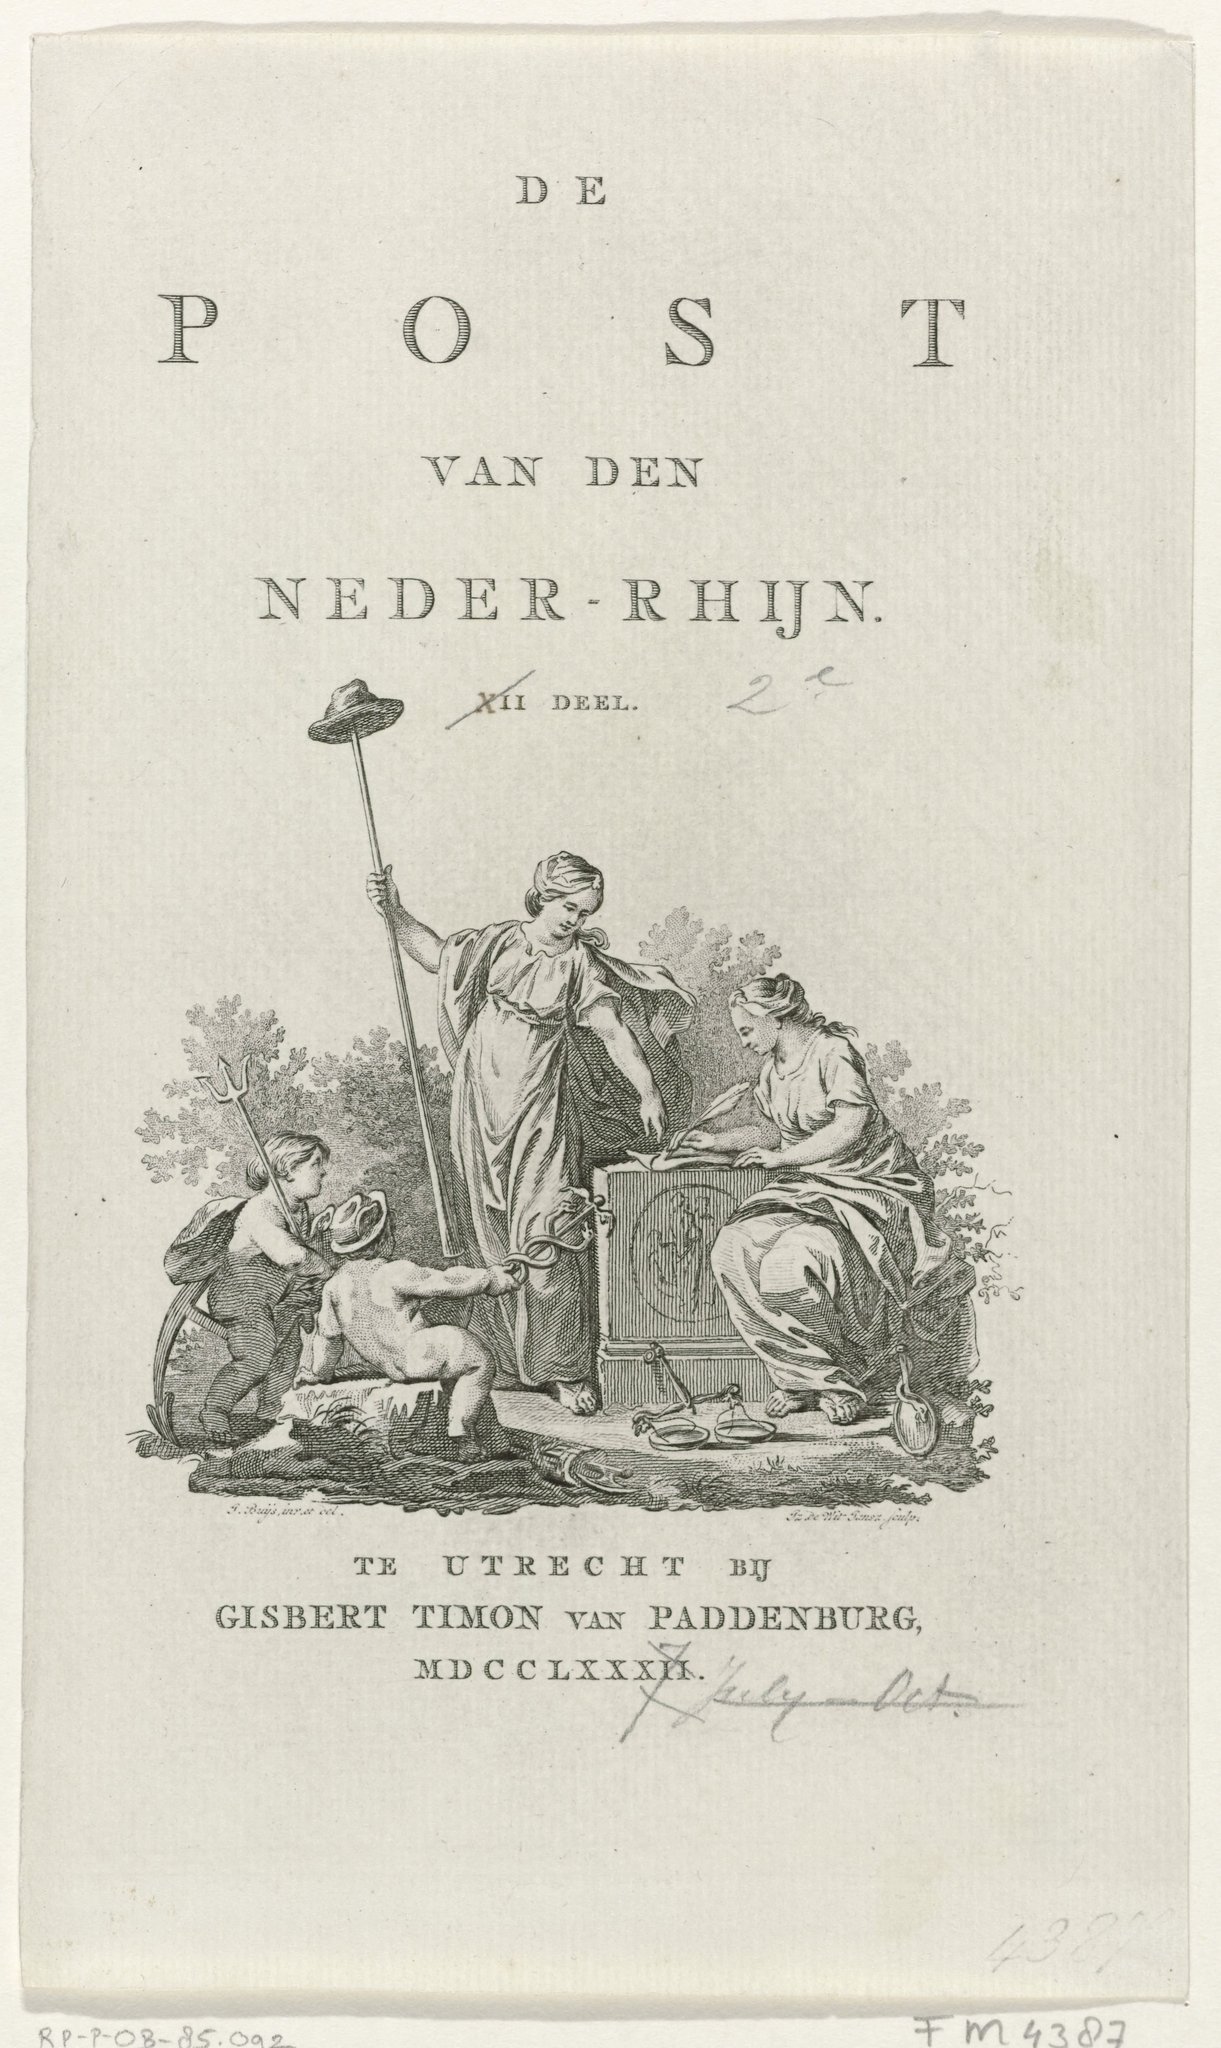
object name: print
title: Titelpagina: De Post van den Neder-Rhijn, dl. II, 1782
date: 1782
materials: paper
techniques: engraving, etching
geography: utrecht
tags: 'politica' (ripa), freedom, liberty; 'libertà' (ripa) (+ abstract concept represented by female figure), patriots (1780-1795)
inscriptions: collector's mark: Lugt 2228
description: Titelpagina van het patriotische tijdschrift De Post van den Neder-Rhijn, dl. II, 1782. Allegorische voorstelling met Staatkunde, schrijvend bij een steen, bijgestaan door Vrijheid en twee kindertjes met symbolen van Mercurius en Neptunus.